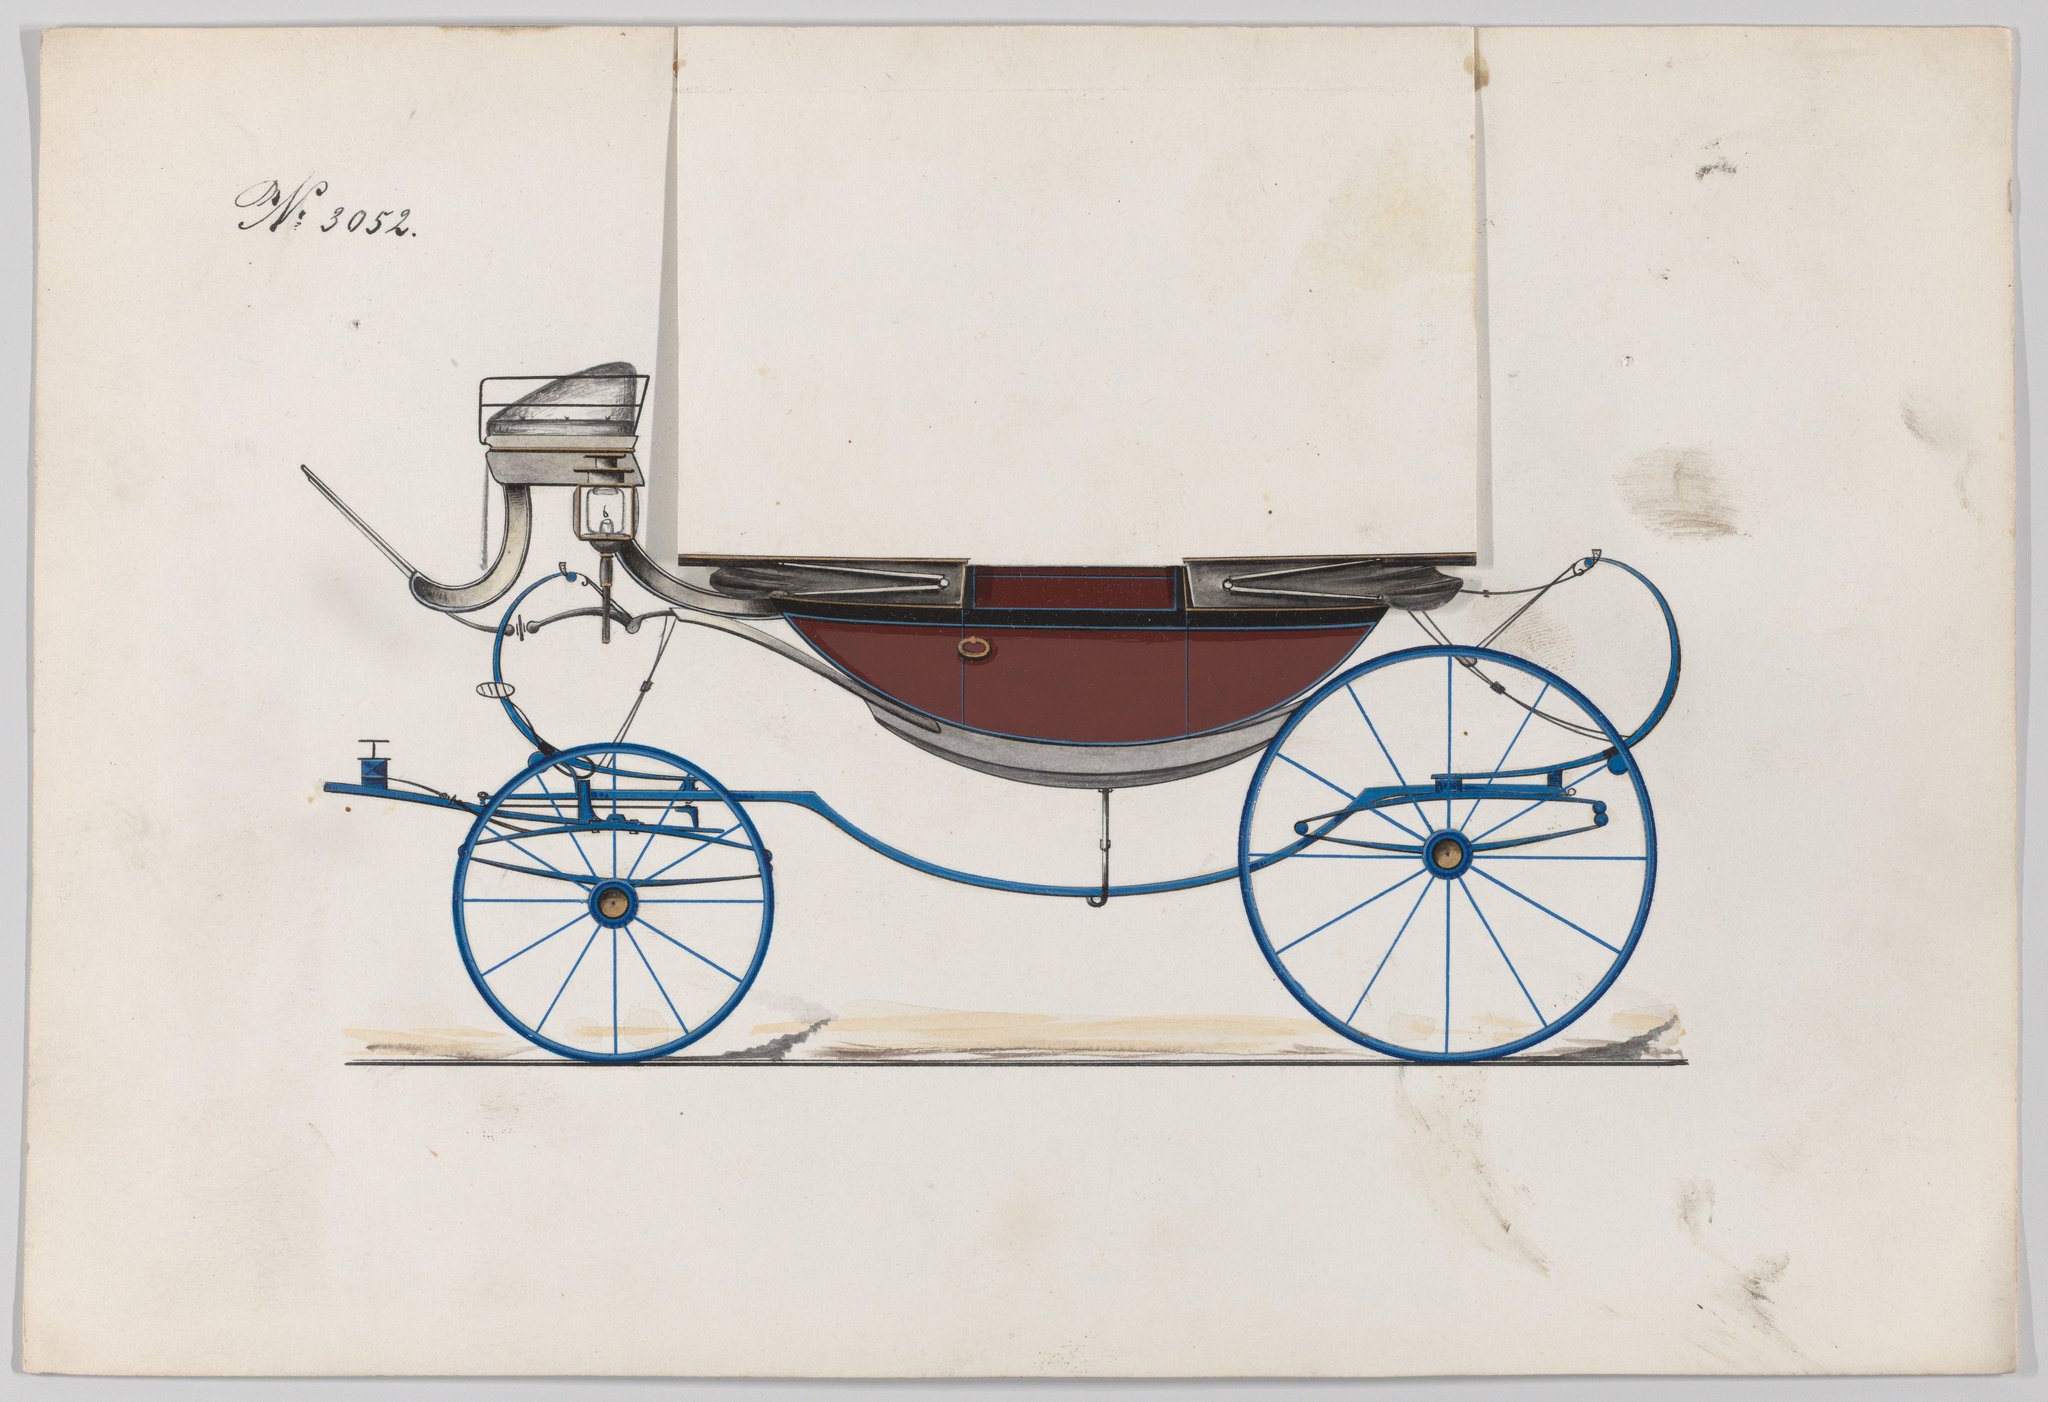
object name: drawing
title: Design for Landau, No. 3052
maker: brewster & co.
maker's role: manufacturer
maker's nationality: american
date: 1874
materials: gouache, gum arabic, ink, watercolor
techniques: pen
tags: carriages